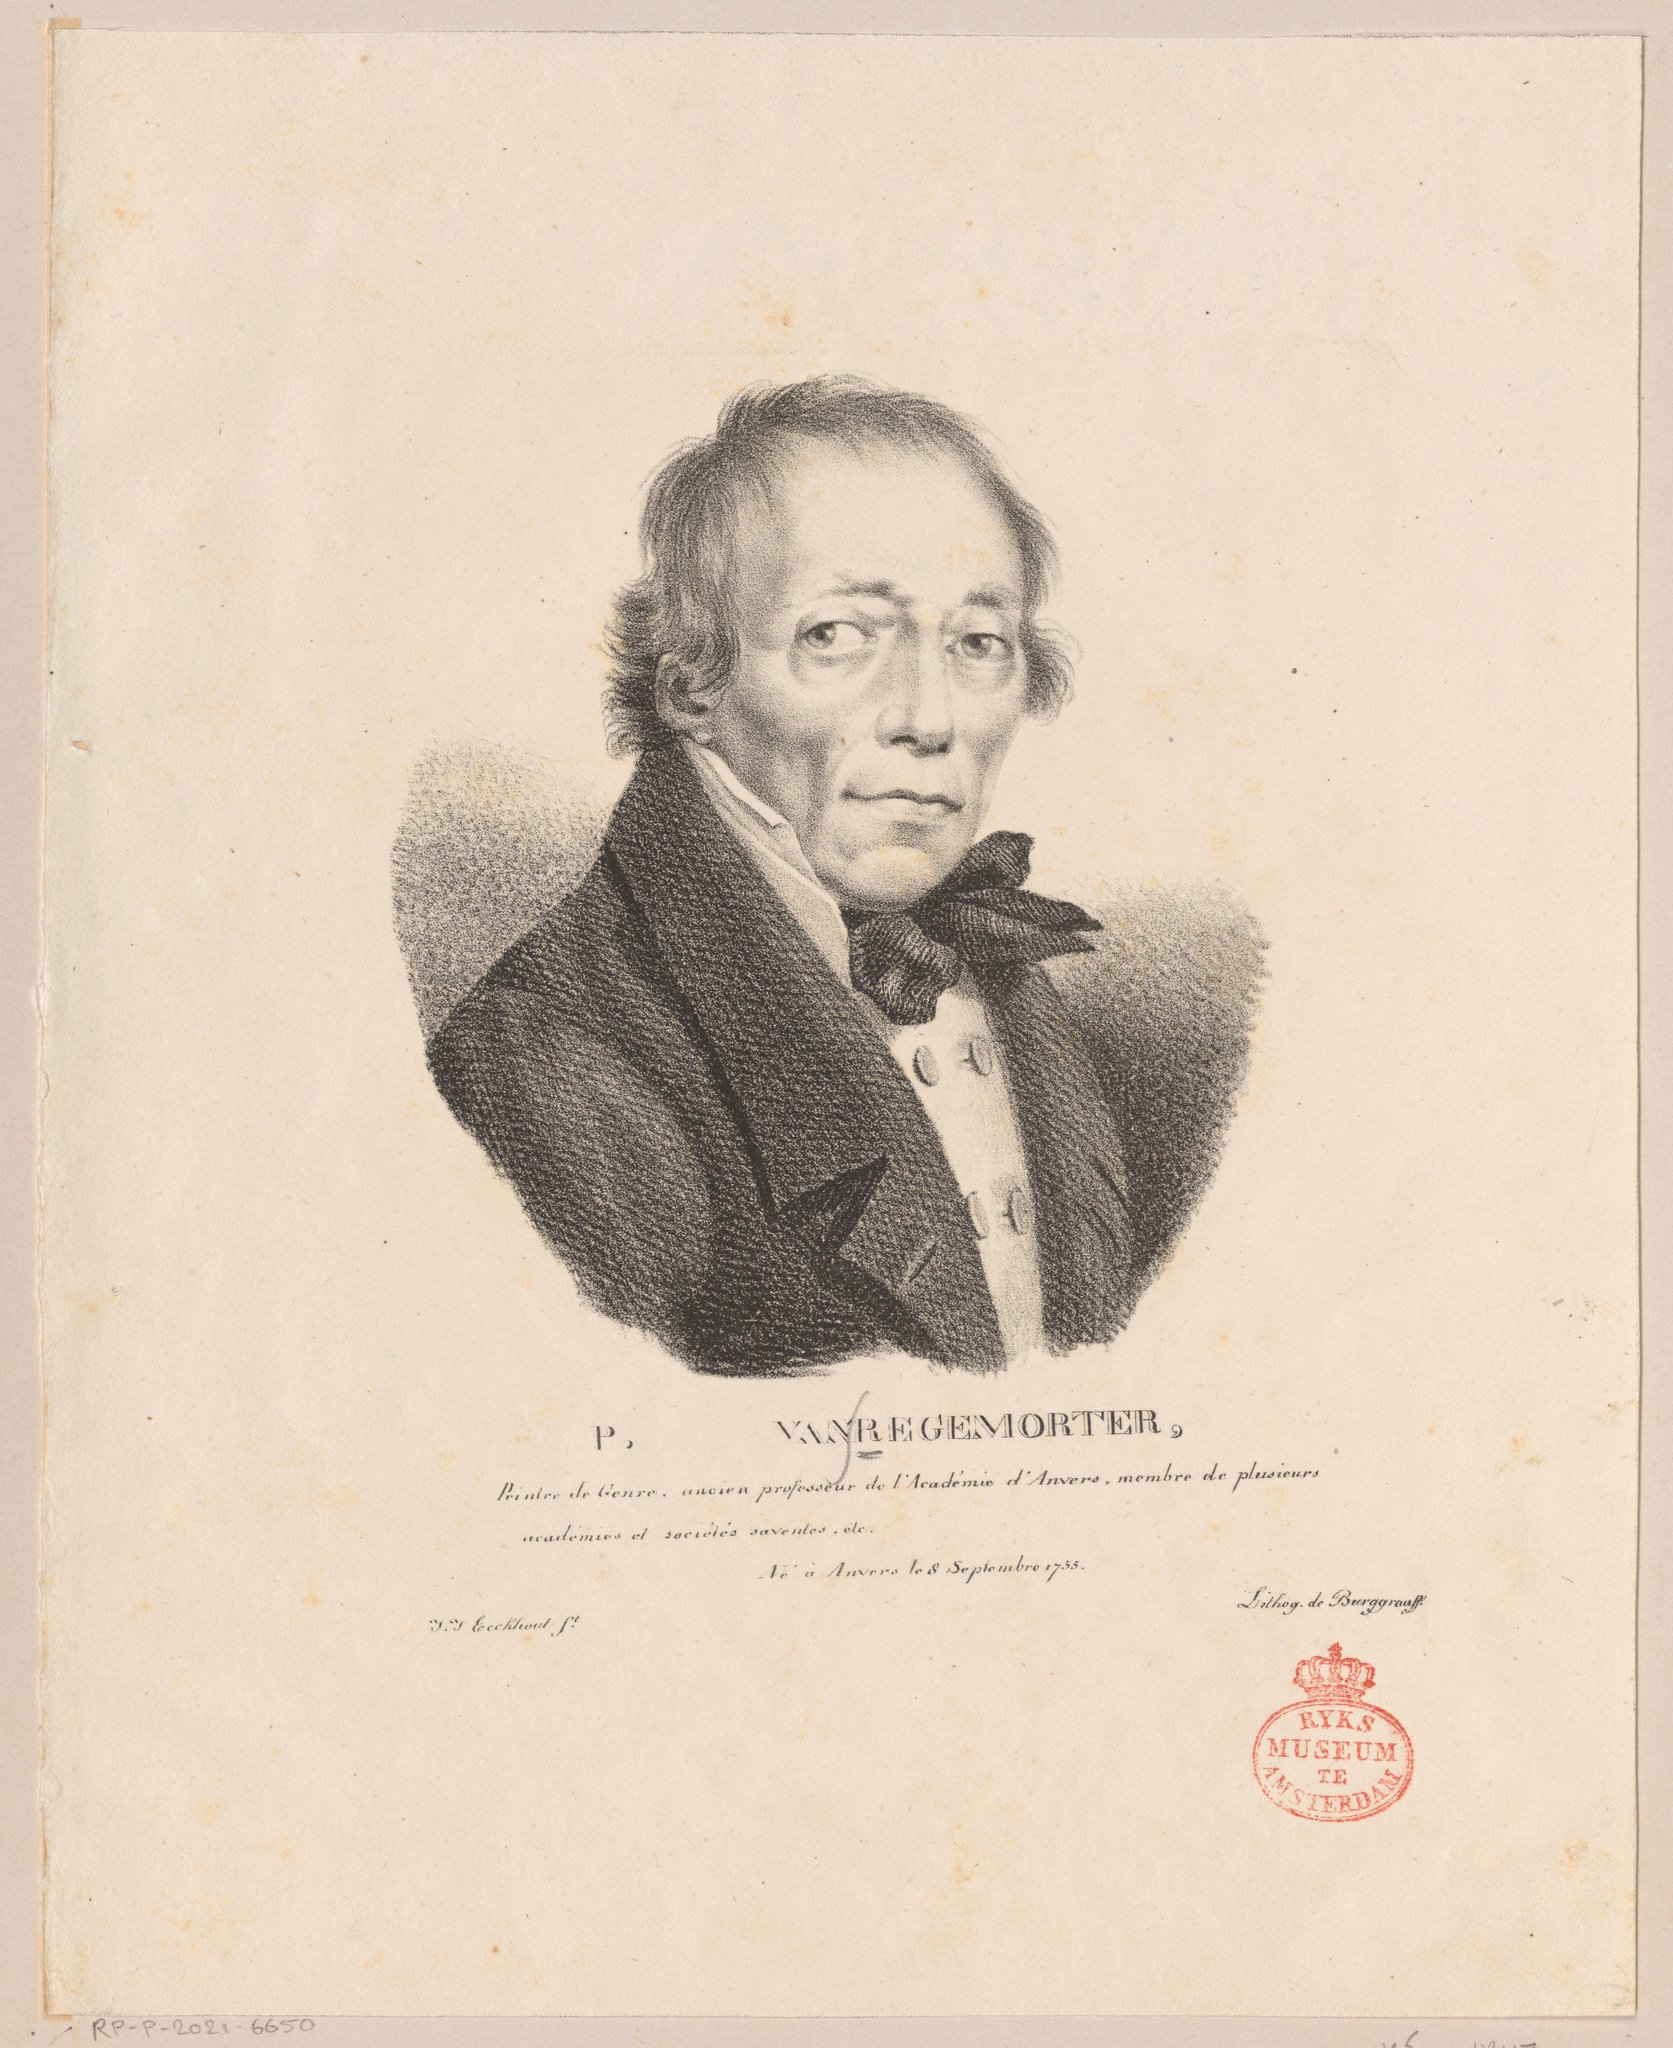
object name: print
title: Portret van Petrus Johannes van Regemorter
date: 1803-1850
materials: paper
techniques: lithograph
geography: brussels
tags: painter, conservator, petrus johannes van regemorter, historical persons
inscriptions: collector's mark: Lugt 12